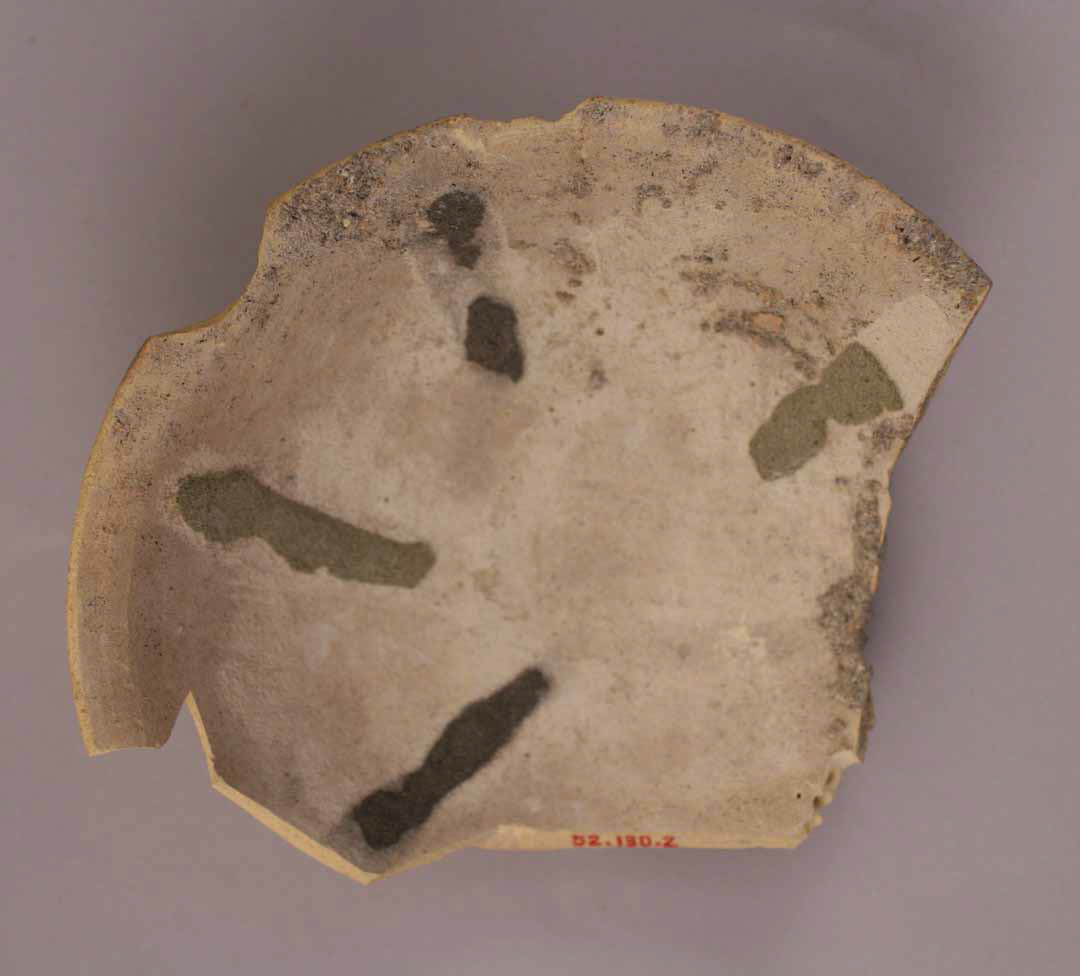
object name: fragment of a bowl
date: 801-900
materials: earthenware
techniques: glazing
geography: iraq